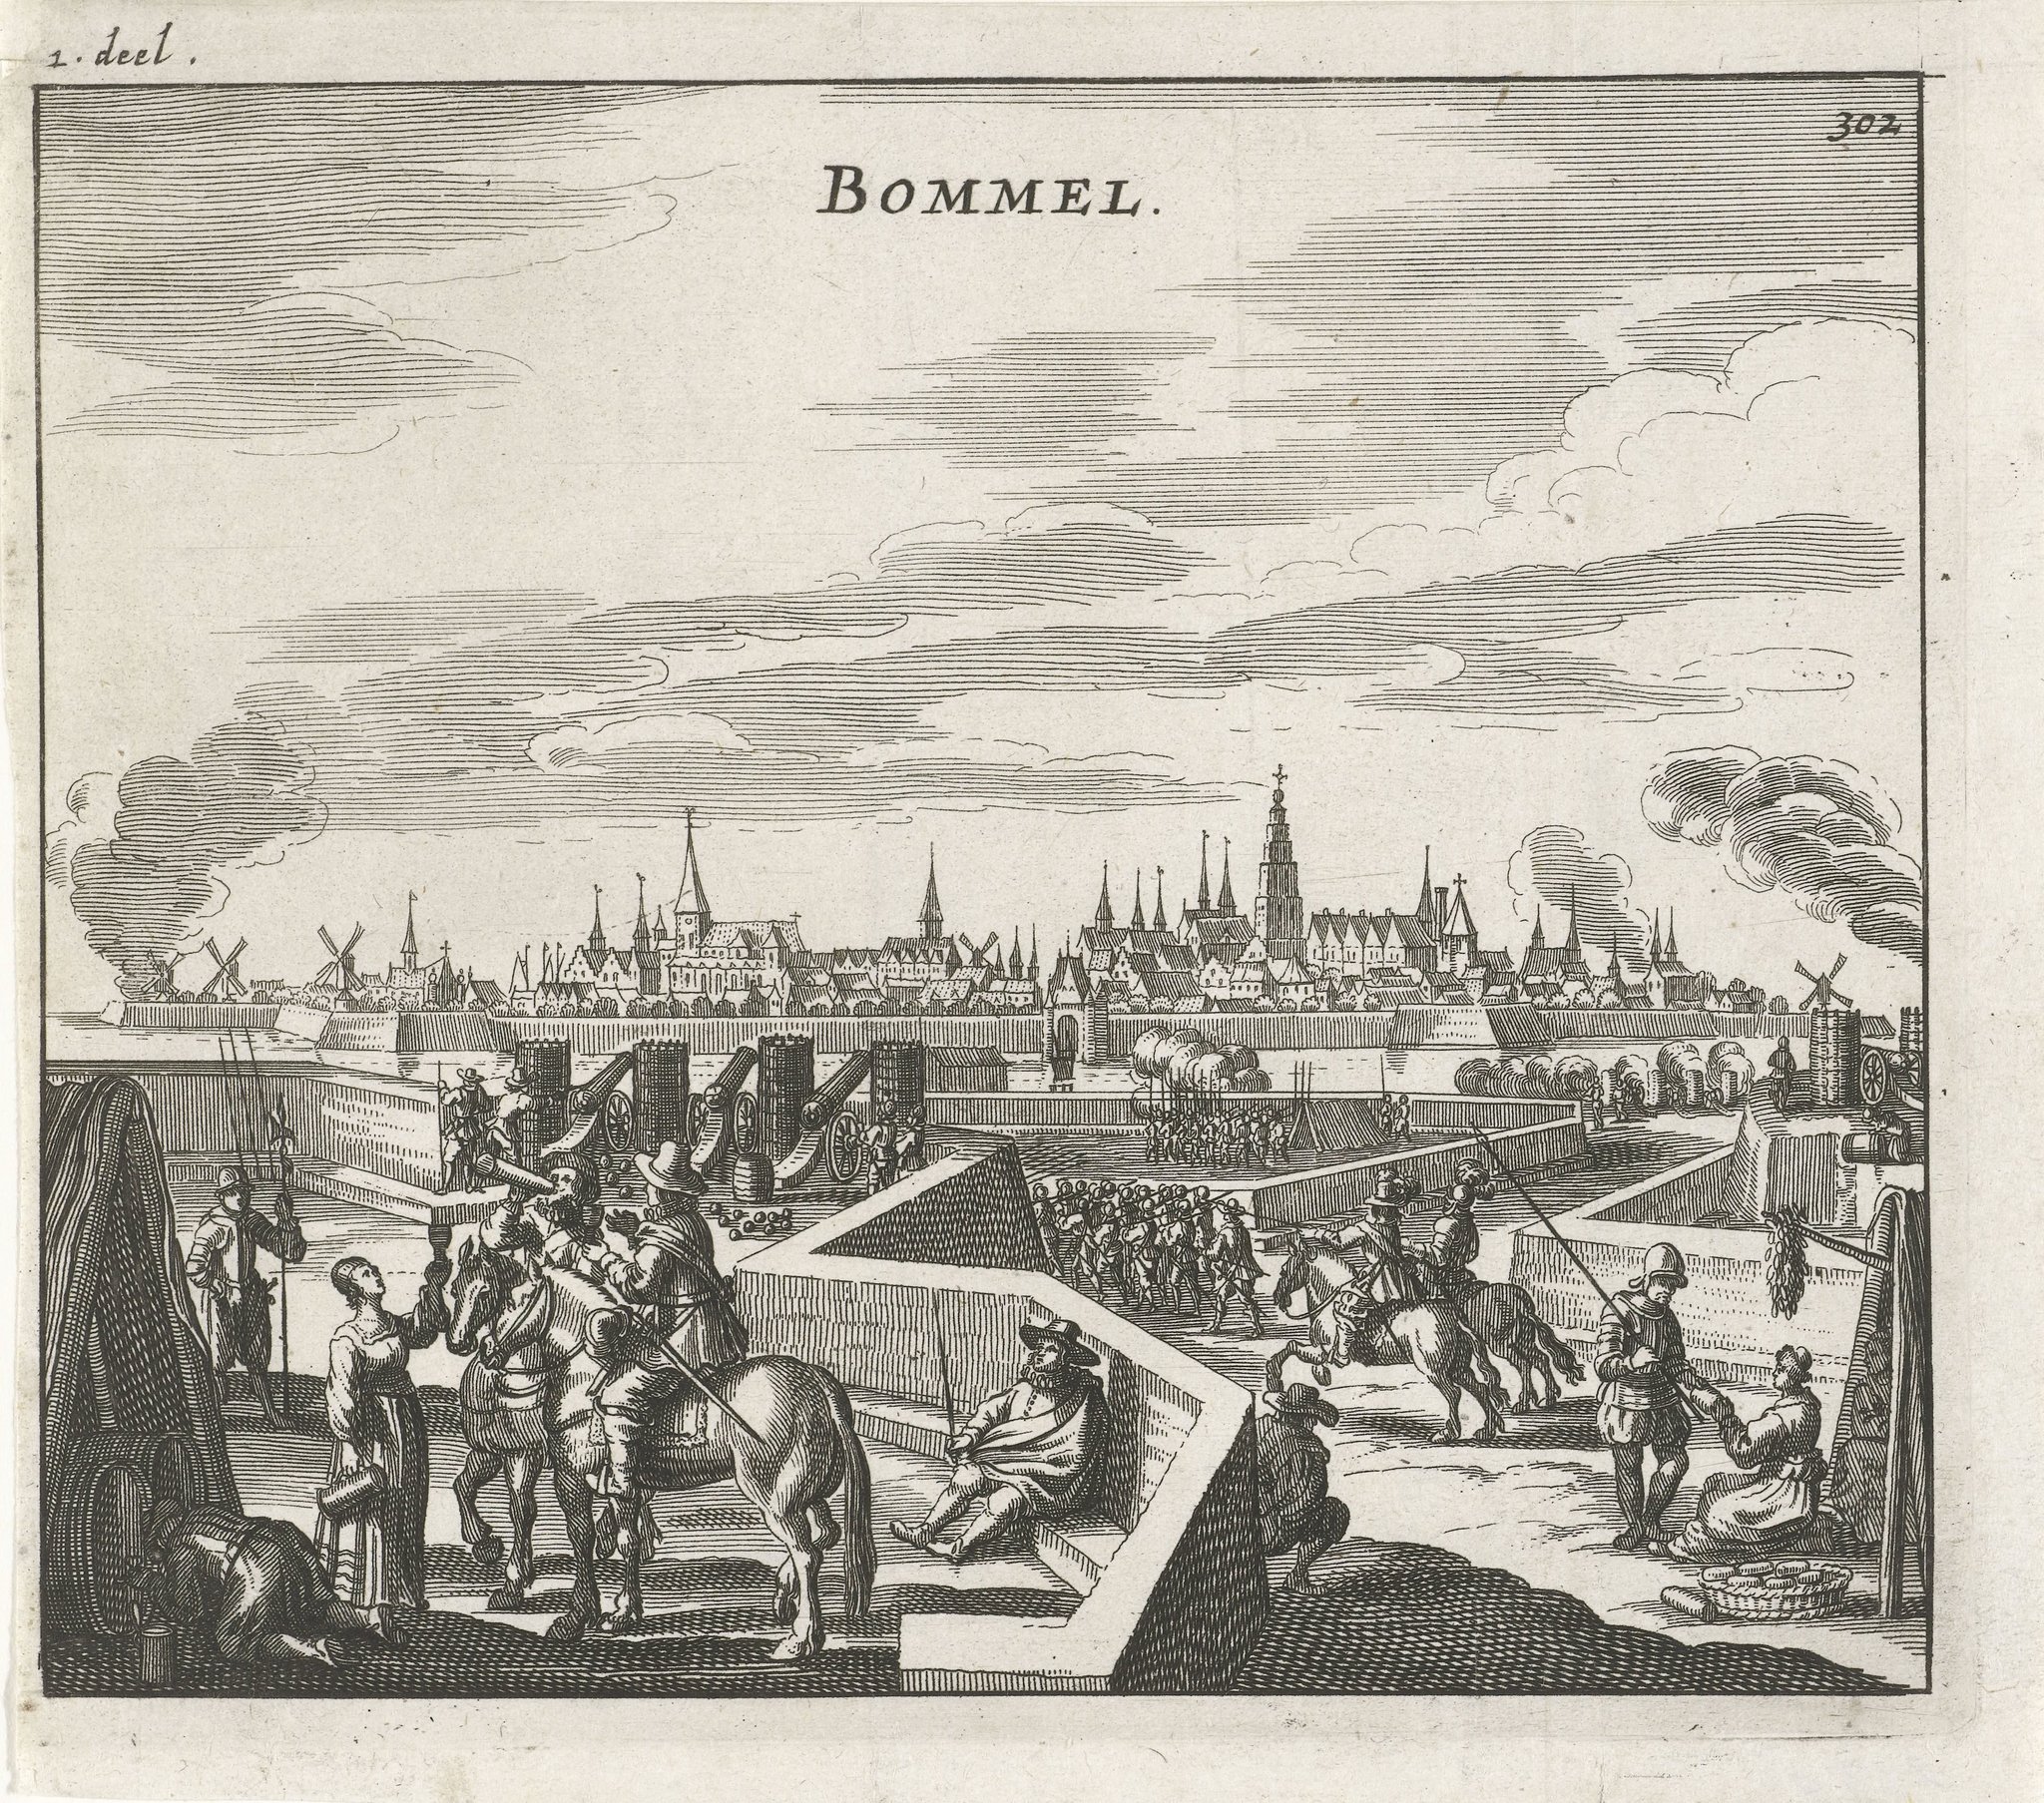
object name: print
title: Beleg van Bommel, 1599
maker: Anonymous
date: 1625-1699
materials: paper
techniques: etching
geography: northern netherlands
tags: siege, position war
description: Illustratie uit een onbekend werk over de militaire wapenfeiten van de prinsen van Oranje, dl. 1, p. 302.